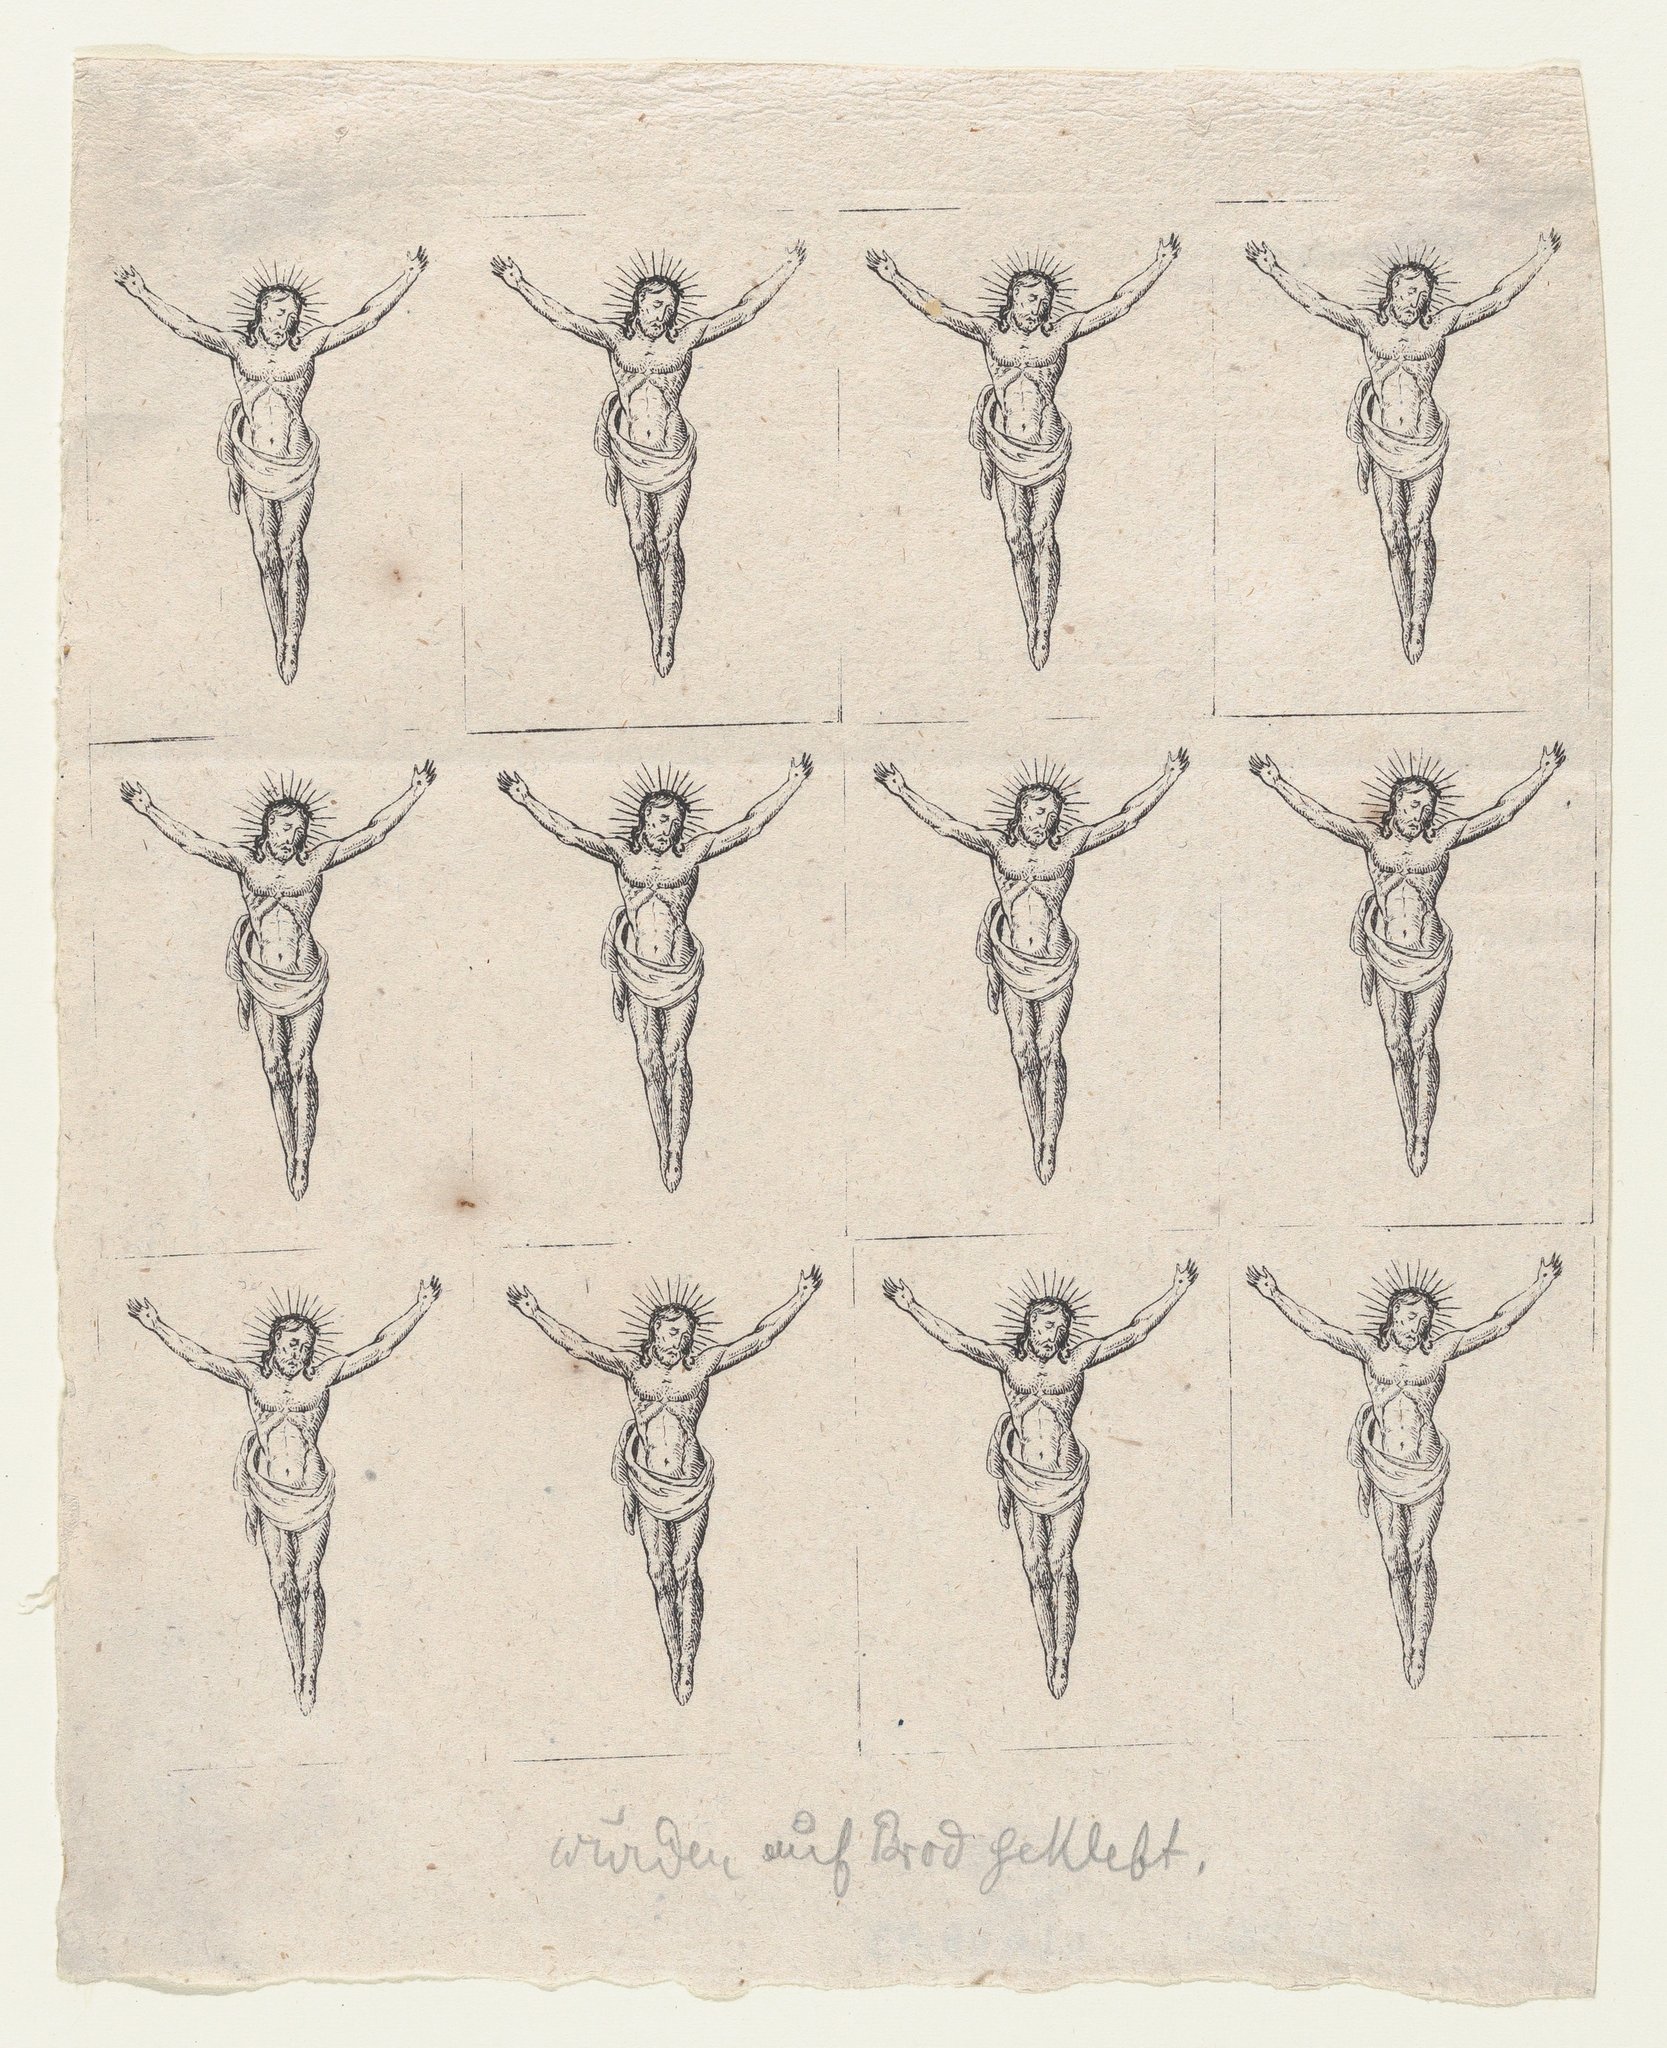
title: Sheet of Twelve Crucified Christs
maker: anonymous, german, 19th century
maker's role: artist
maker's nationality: german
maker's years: 1800-1899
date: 1801-1900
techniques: lithograph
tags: christ,crucifixion